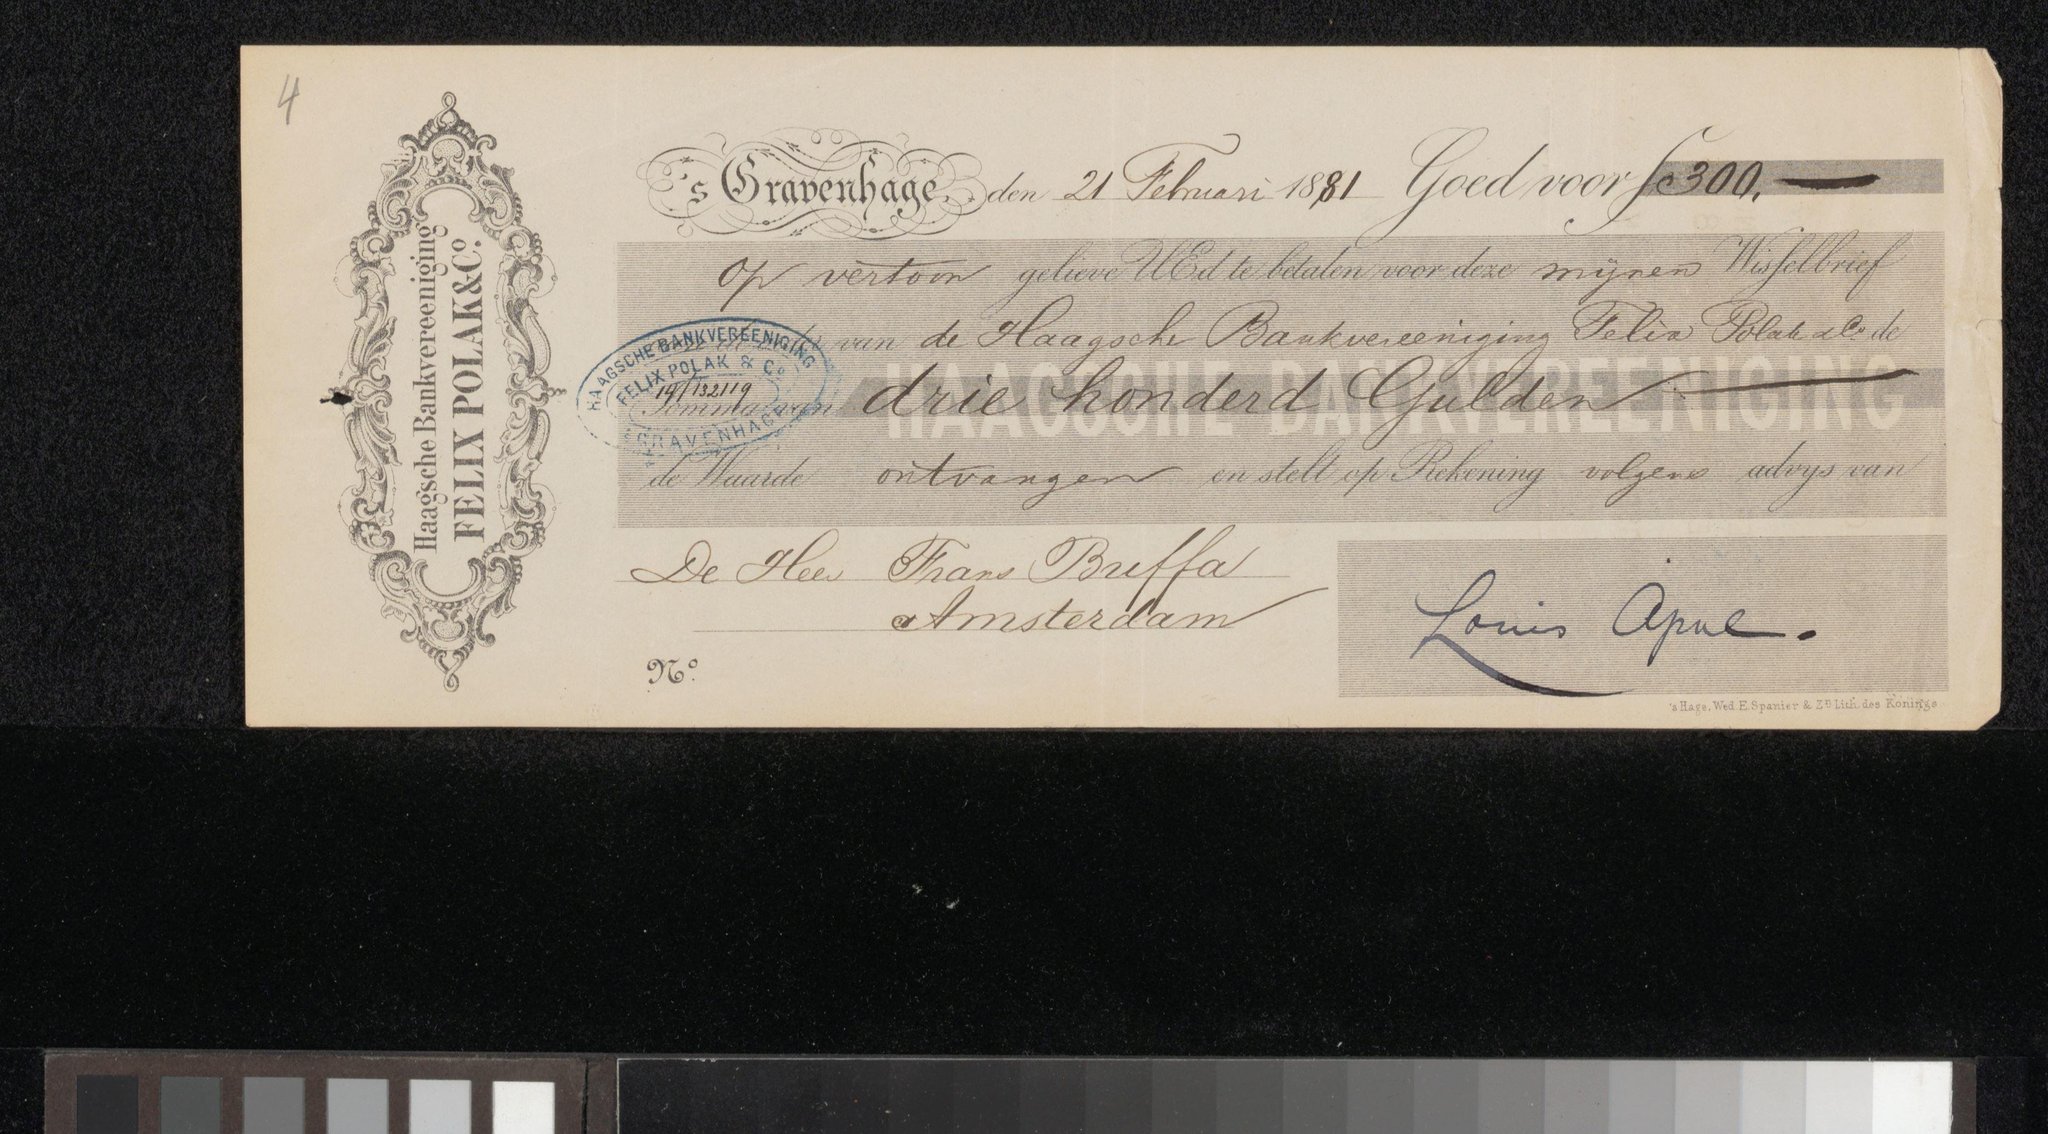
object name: ontvangstbewijs, kwitantie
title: Ontvangstbewijs aan Louis Apol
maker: louis apol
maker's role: draughtsman, painter, print maker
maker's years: 1850-1936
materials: ink, paper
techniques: pen, printing, writing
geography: the hague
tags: publisher, money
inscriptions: collector's mark: Lugt 2233, name: ‘HAAGSCHE BANKVEREENIGING/ FELIX POLAK & Co./ 's GRAVENHAGE’